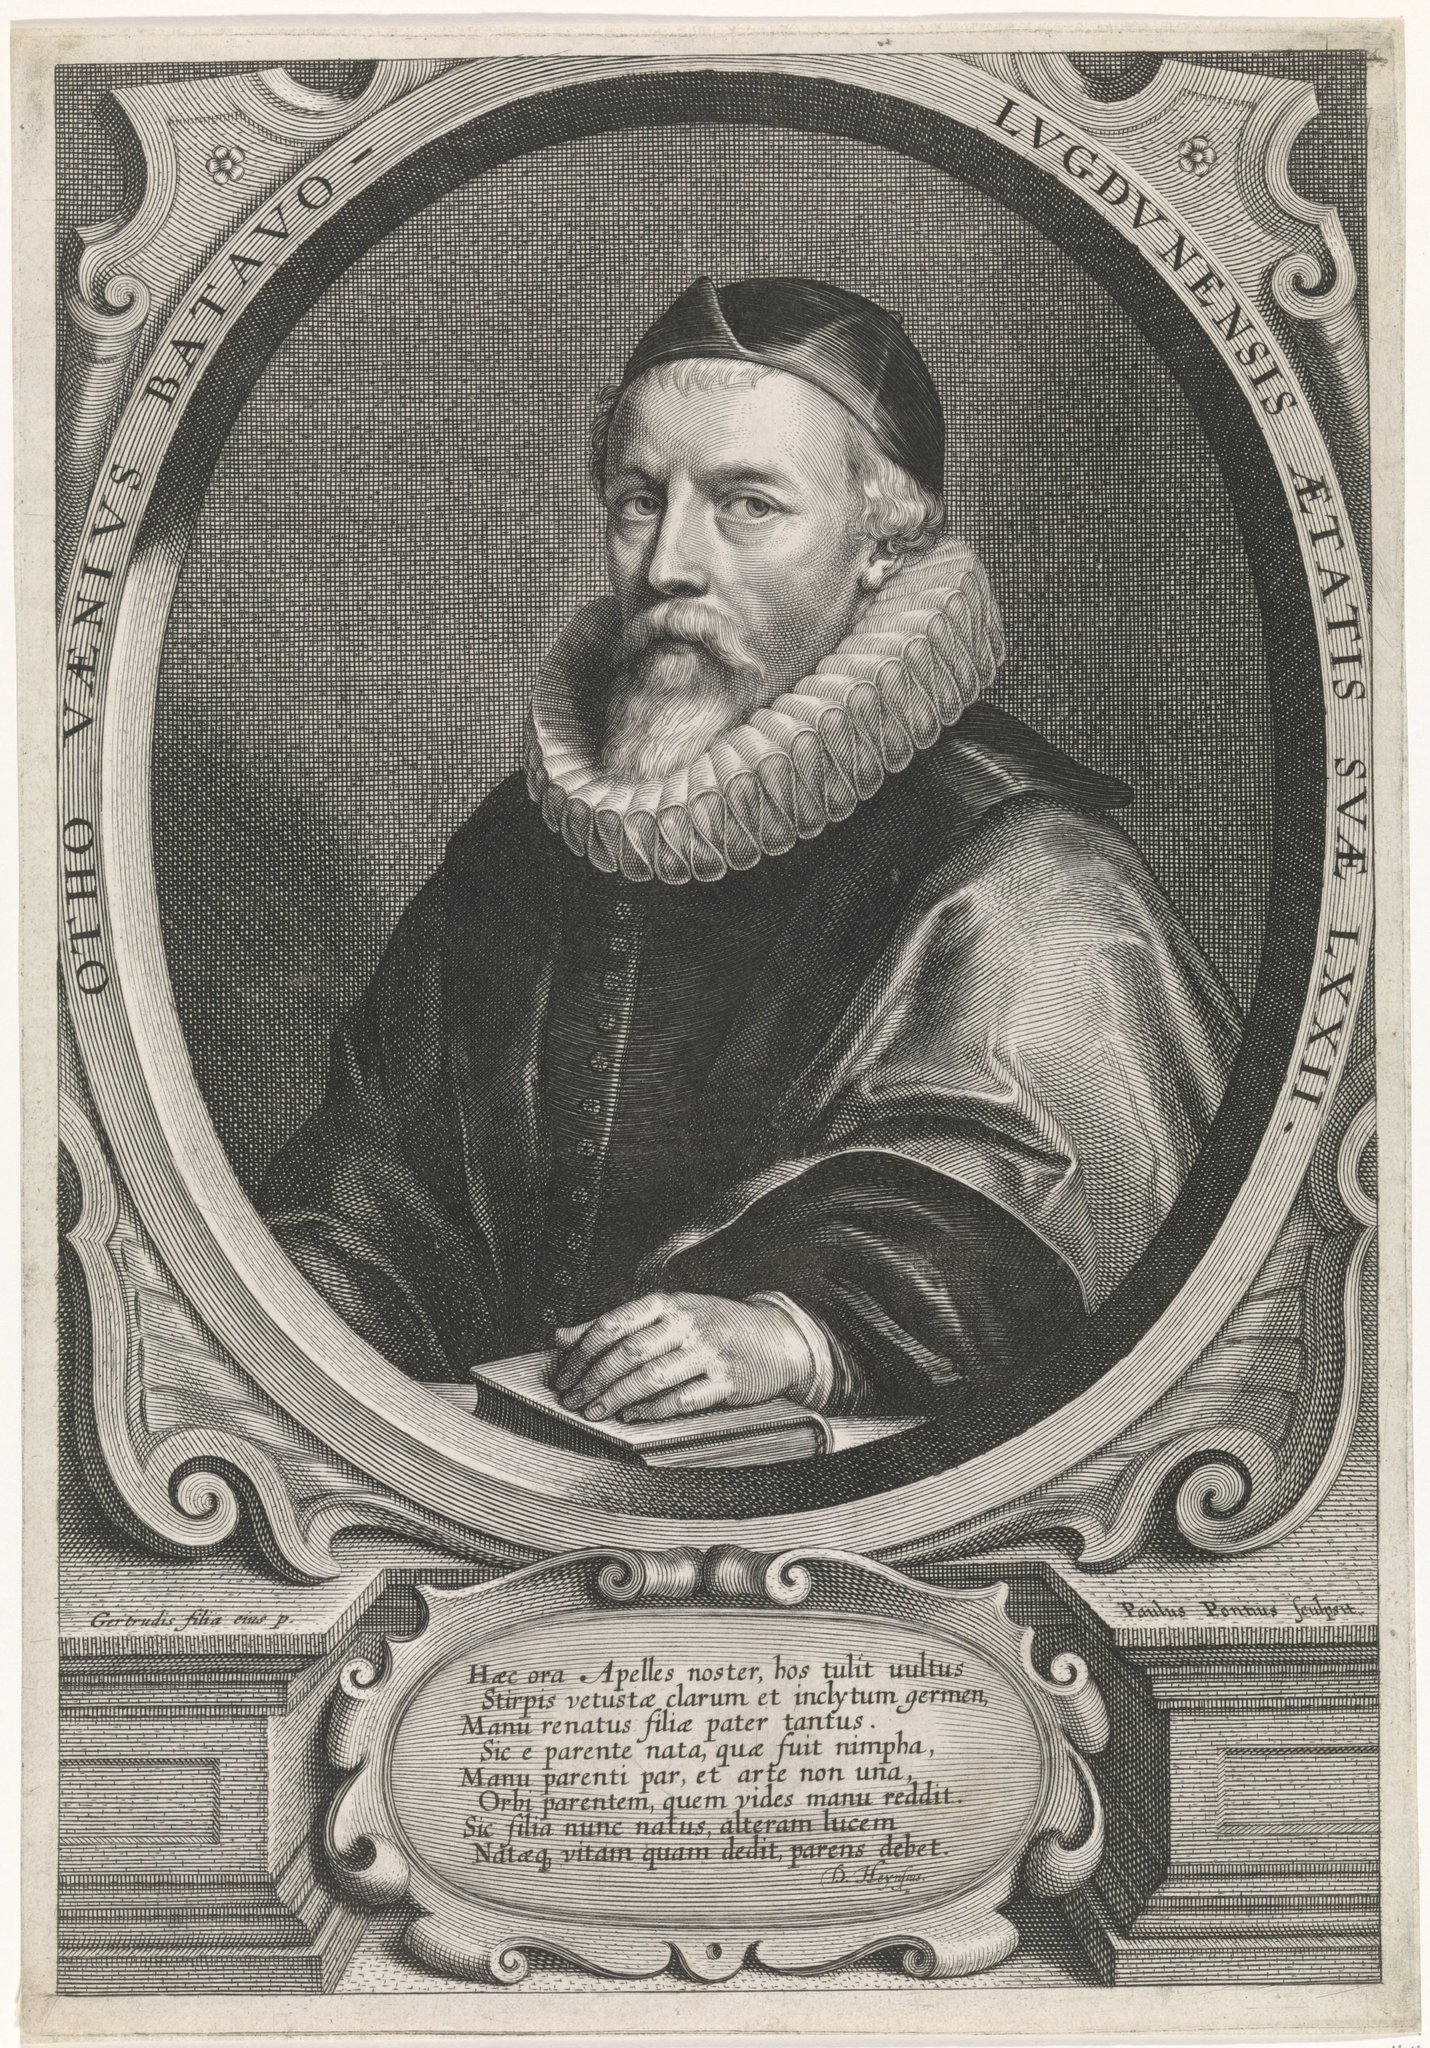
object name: print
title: Portret van de schilder Otto van Veen, op 72-jarige leeftijd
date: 1616-1657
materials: paper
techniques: engraving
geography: antwerp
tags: leiden, painter, draughtsman, otto van veen, portrait, self-portrait of painter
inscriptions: collector's mark: Lugt 2228